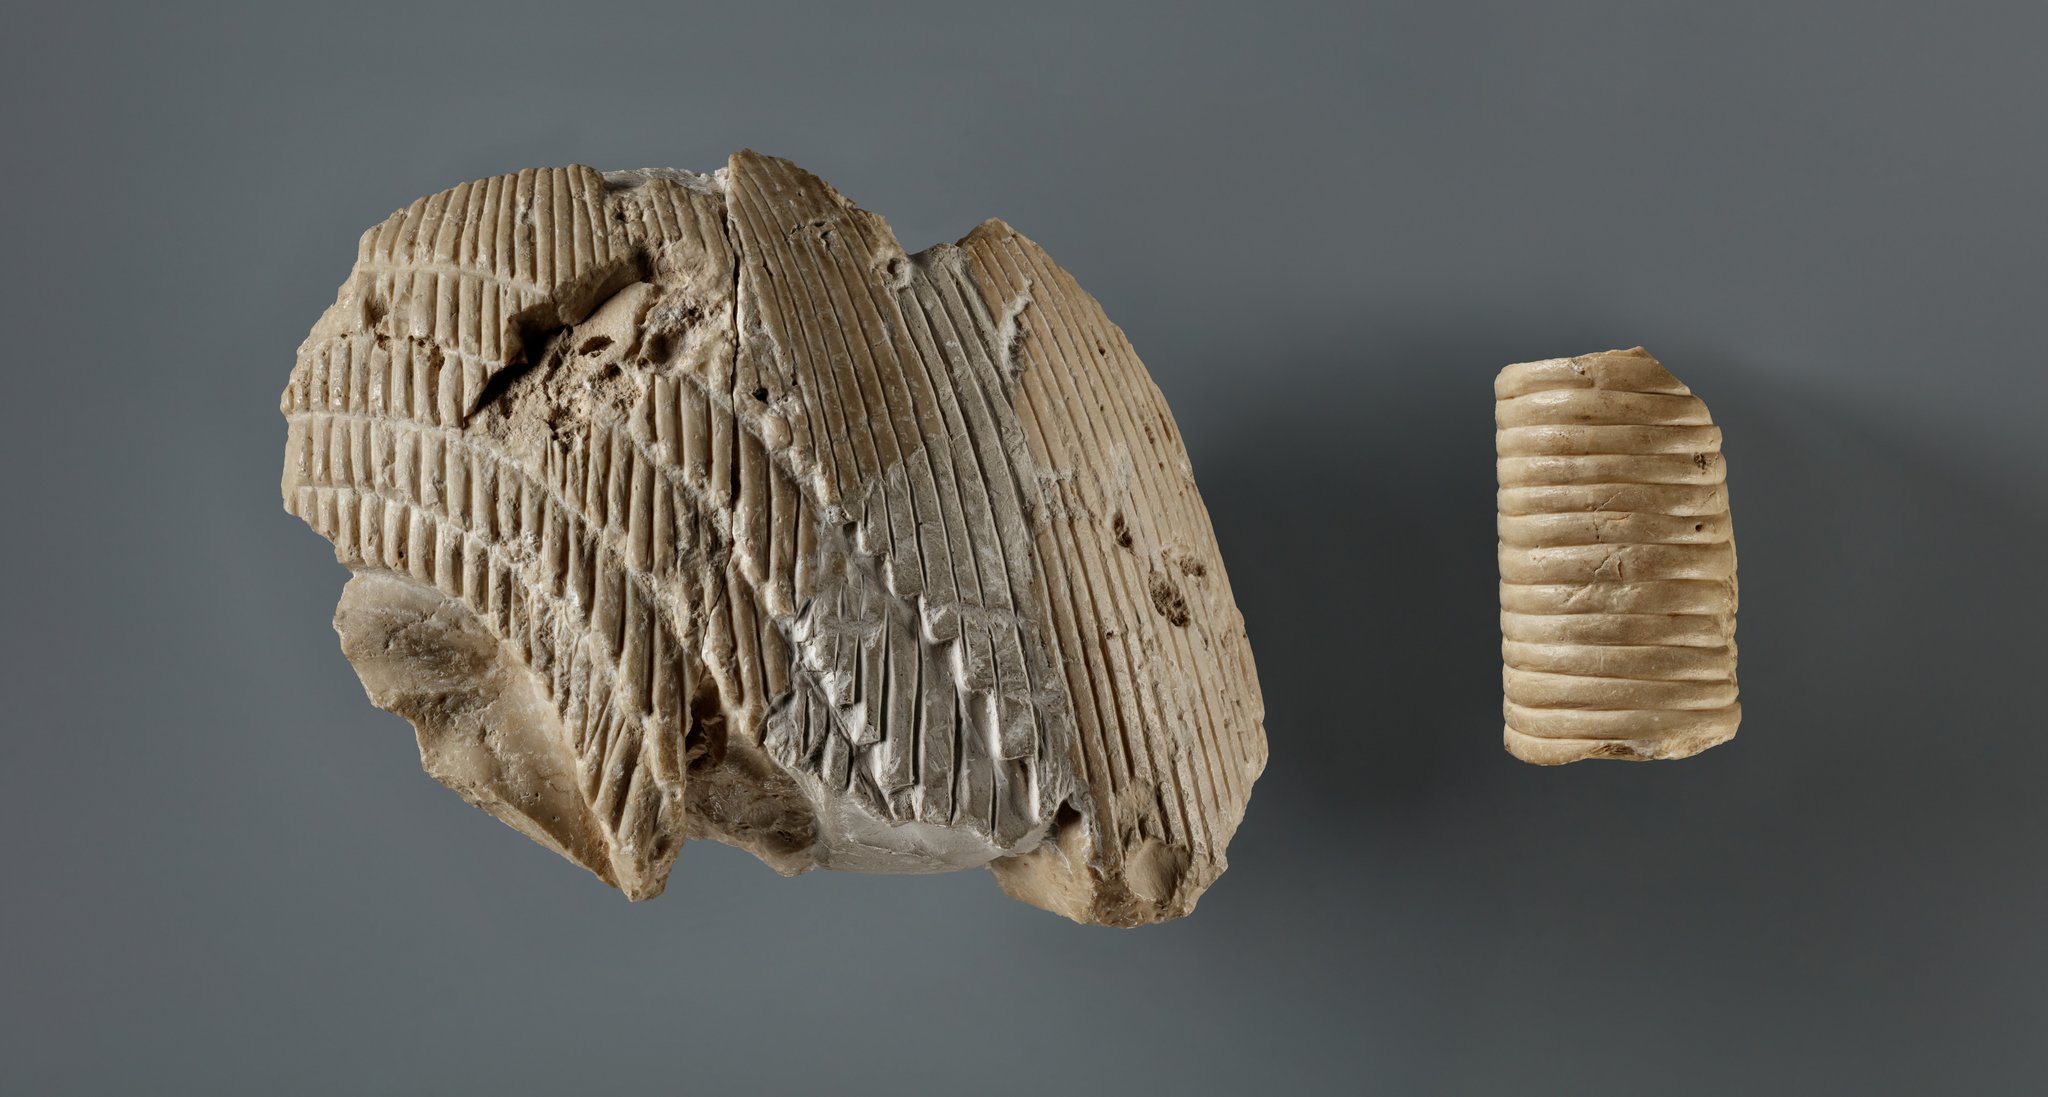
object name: wig and nemes tail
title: Wig (a) and nemes tail (b)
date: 1353-1336 BCE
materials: limestone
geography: egypt